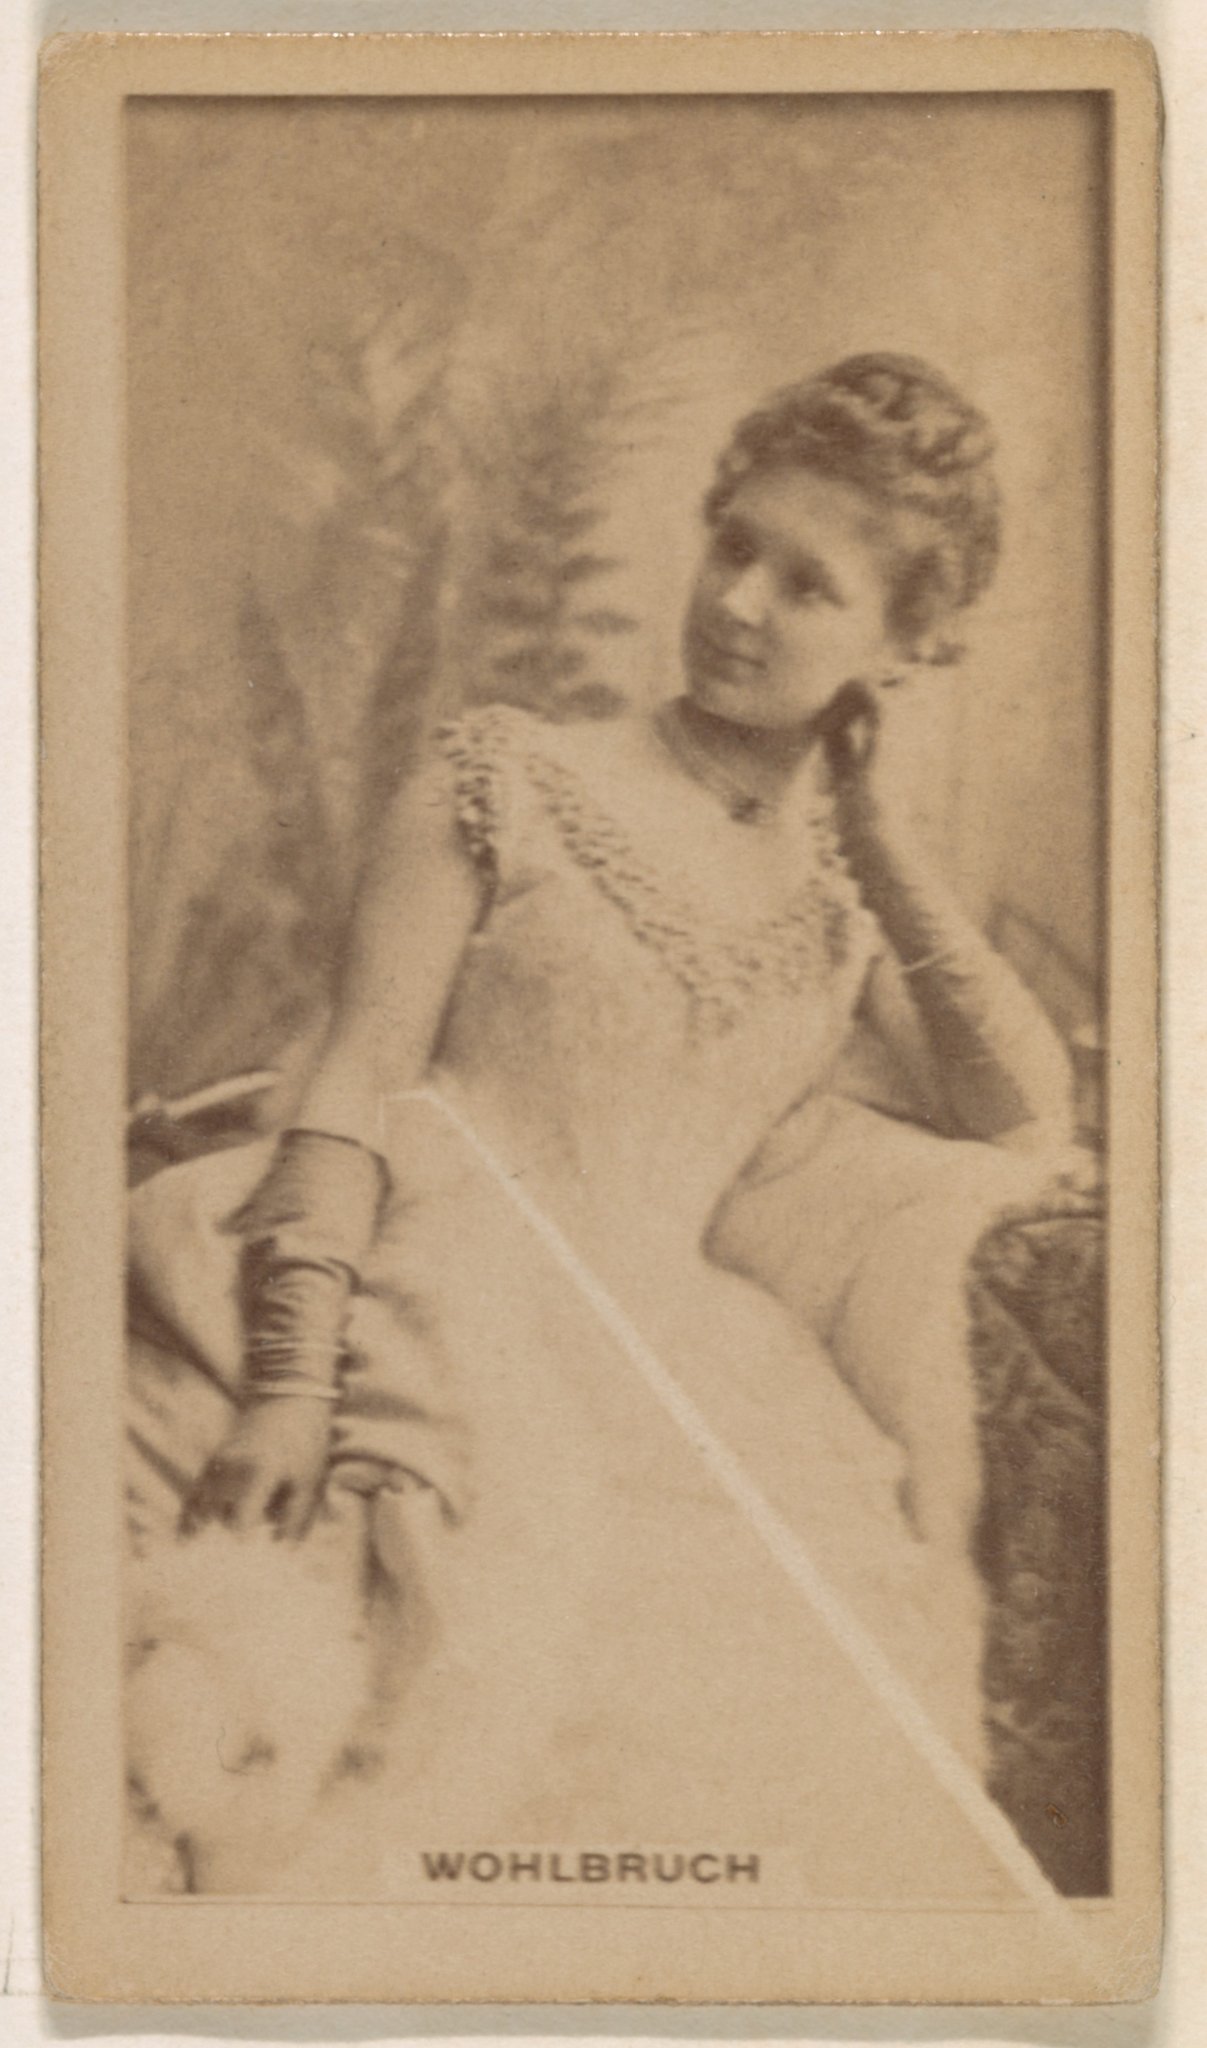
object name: photograph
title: Miss Wohlbruch, from the Actresses series (N245) issued by Kinney Brothers to promote Sweet Caporal Cigarettes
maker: kinney brothers tobacco company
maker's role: publisher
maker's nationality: american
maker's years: 1869-2011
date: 1890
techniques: albumen silver print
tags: portraits,women,actresses